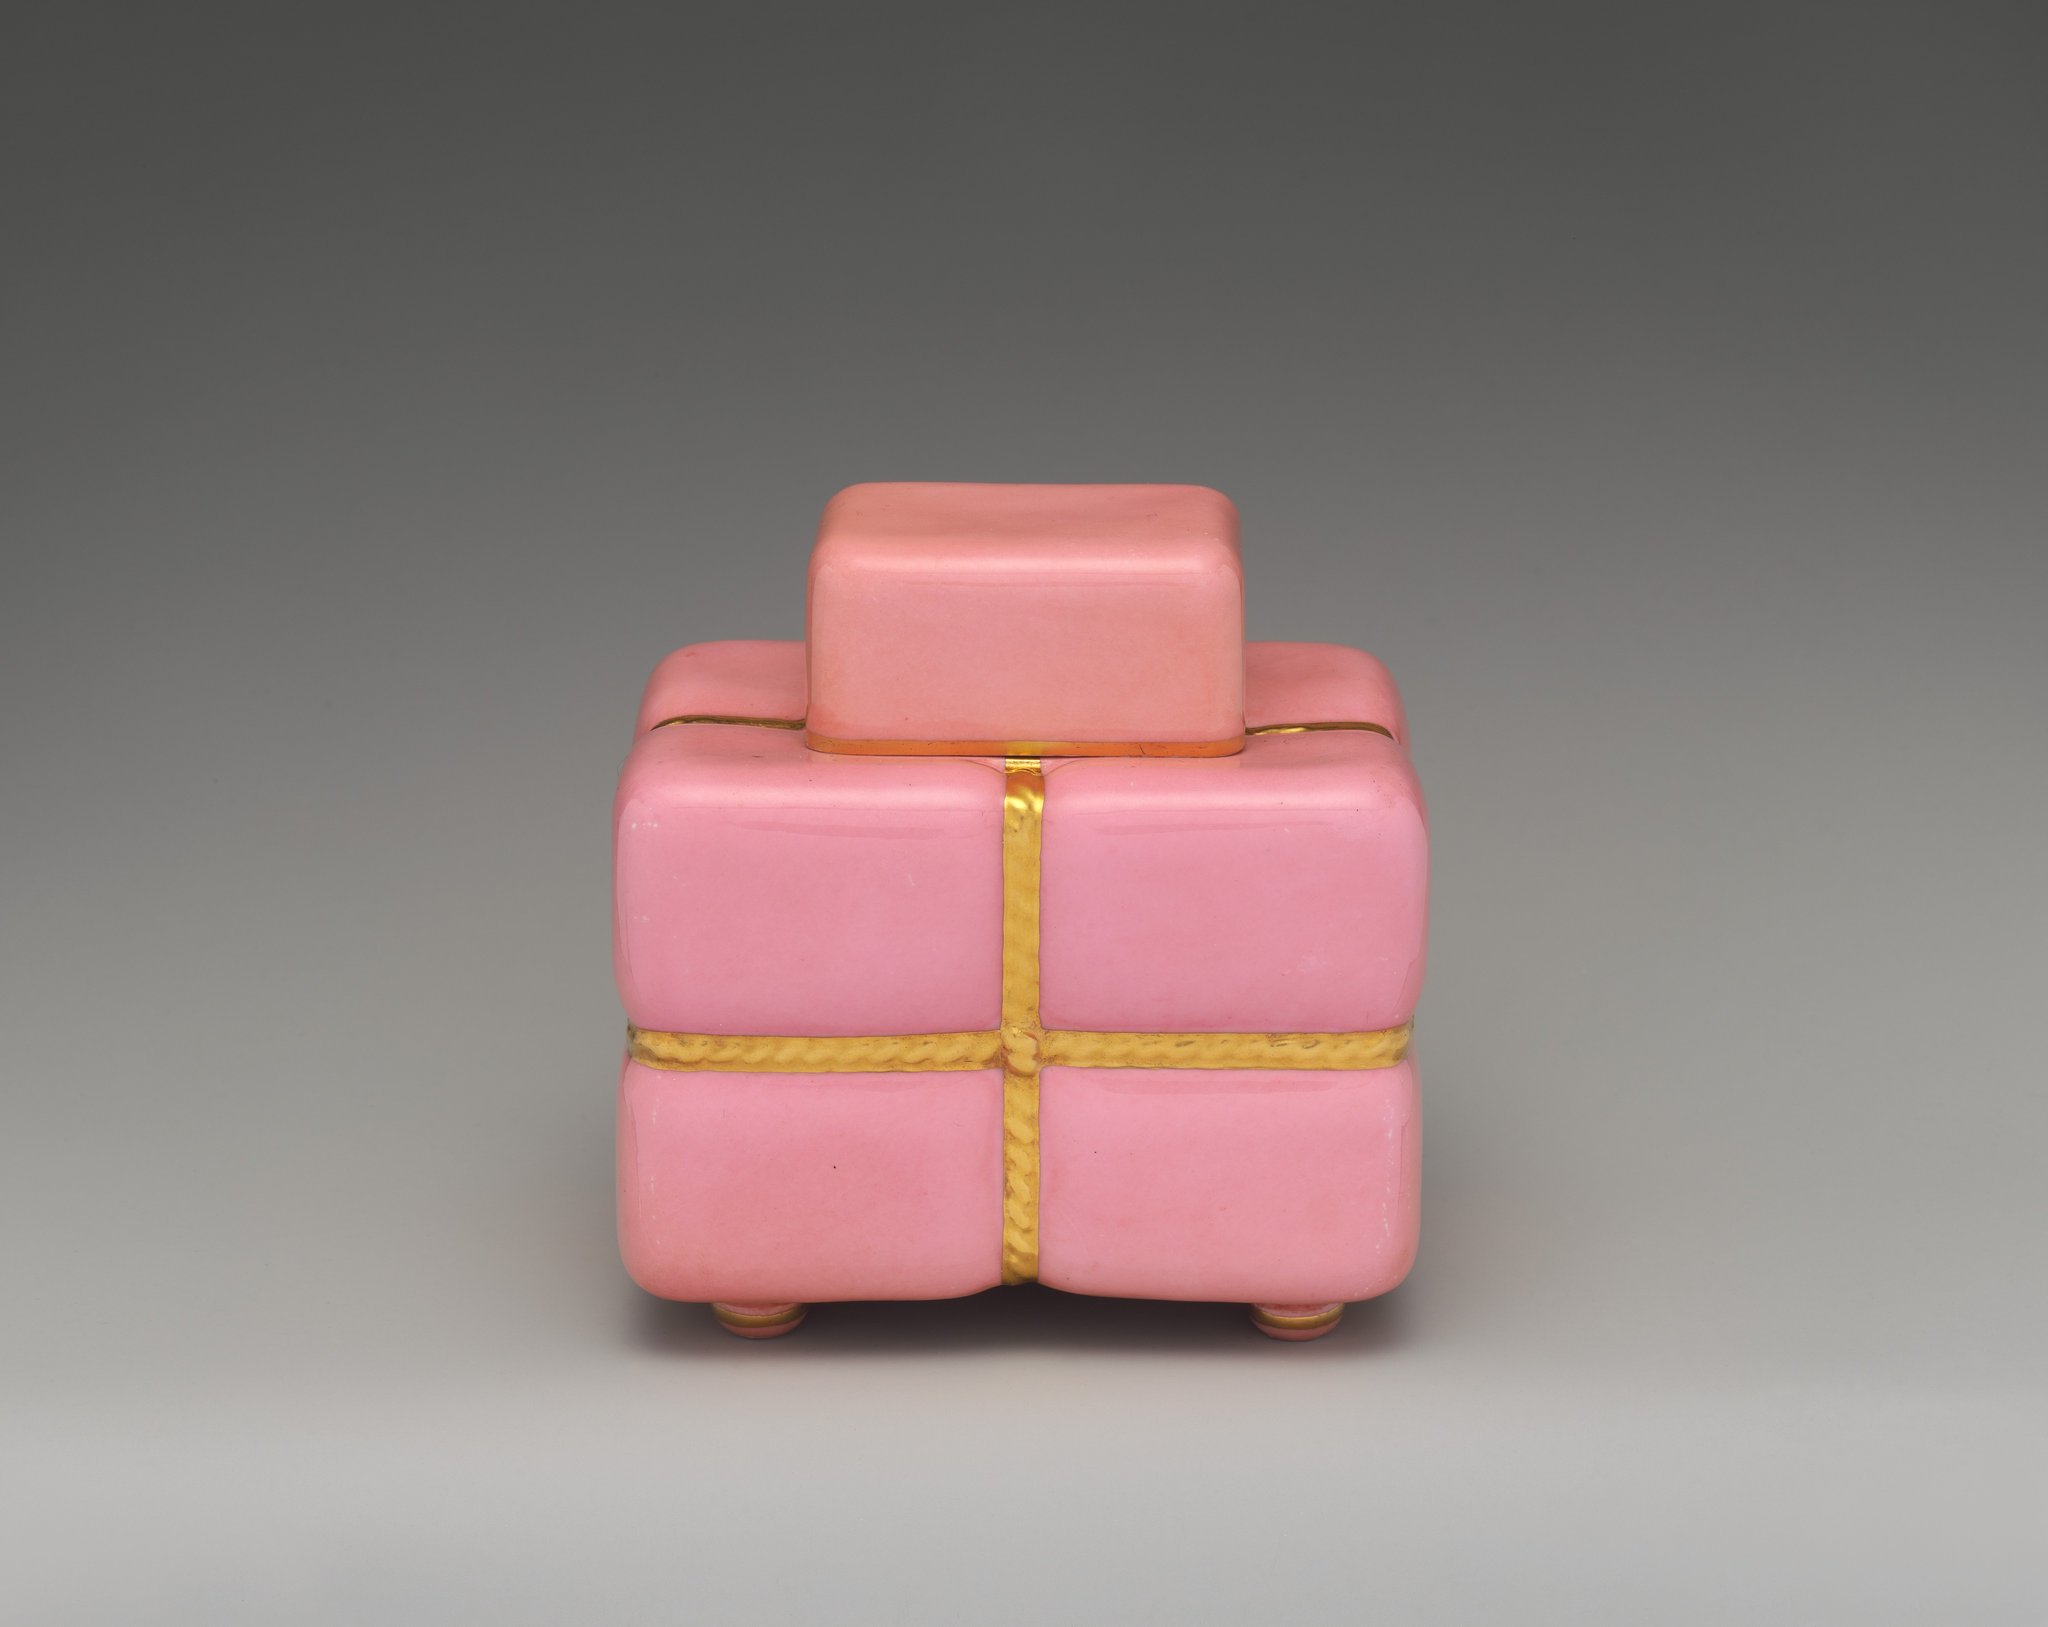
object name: tea caddy with cover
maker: christopher dresser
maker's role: designer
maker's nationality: british, scottish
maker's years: 1834-1904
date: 1891-1900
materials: bone china